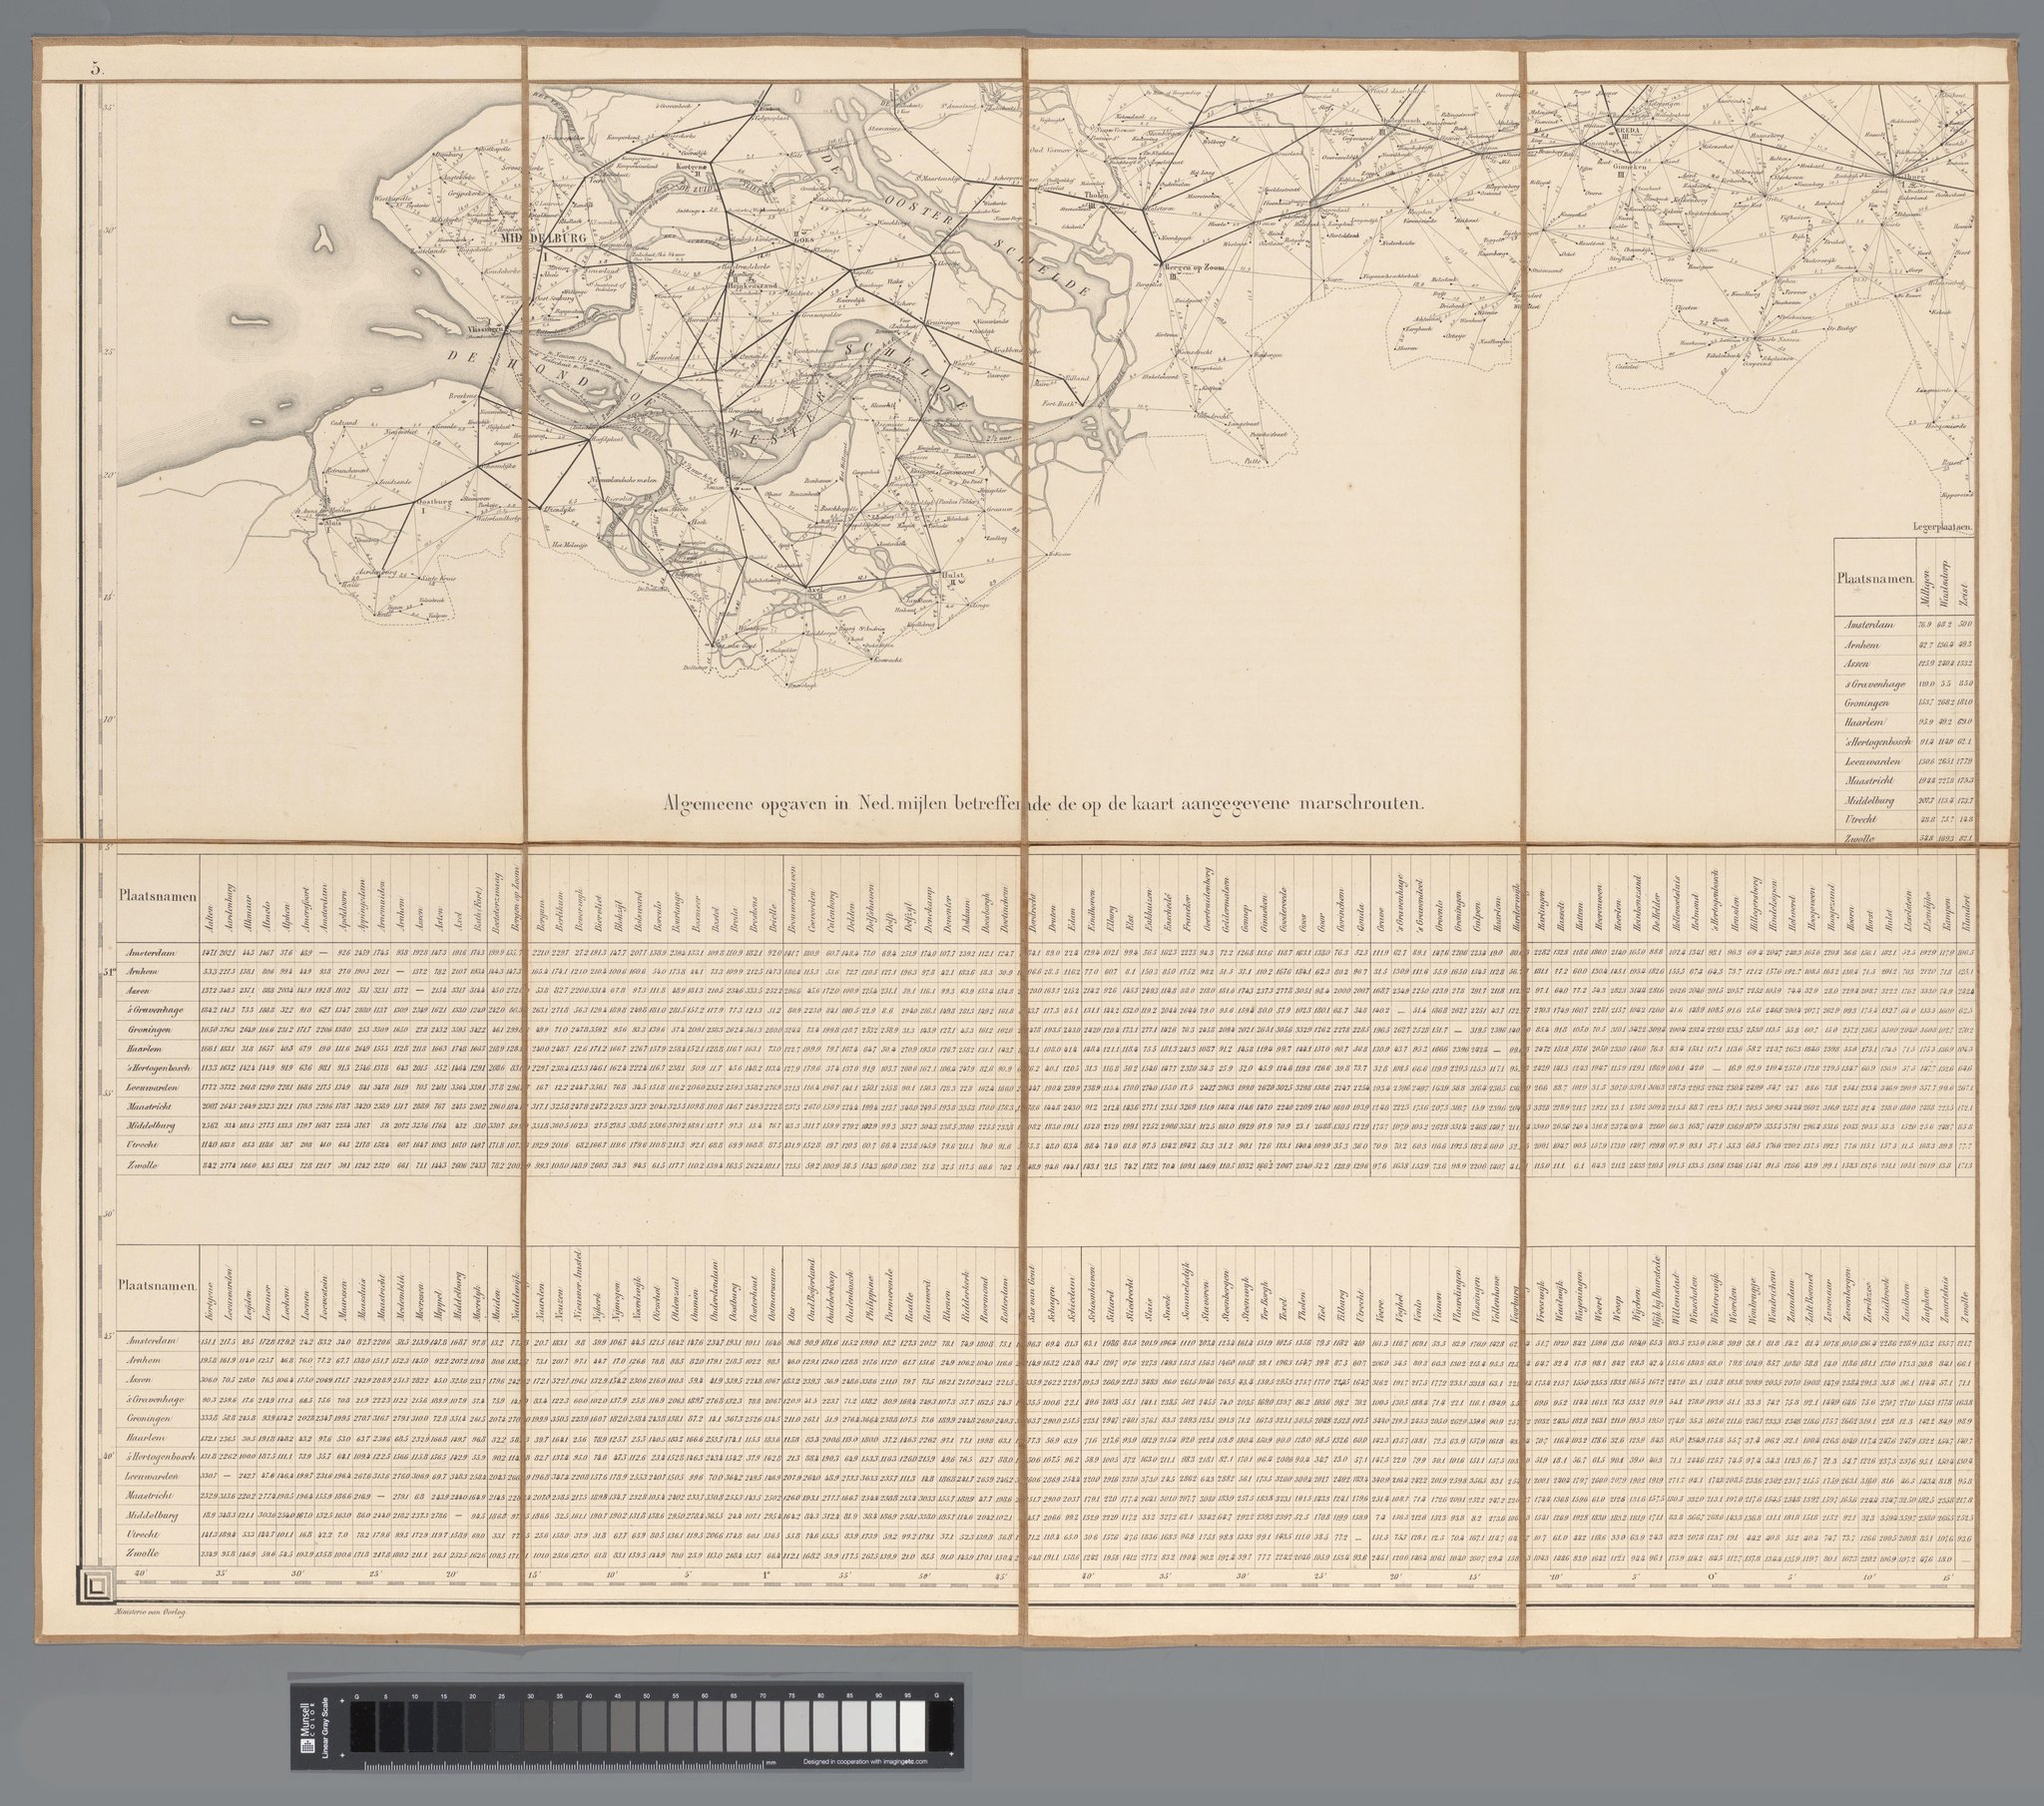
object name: map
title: Afstands-wijzer van het Koningrijk der Nederlanden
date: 1862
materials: linen, paper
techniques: lithograph, printing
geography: the hague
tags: netherlands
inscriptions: date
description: Eén van zes kaartenbladen met legenda (zie NG-934-1 t/m 6), op linnen geplakt, in kartonnen doos, buiten met zwart kunstleer beplakt en aan de binnenkant met groen-zwart ruitjespapier. Gedateerd; blad 3, l.b.: 1862.